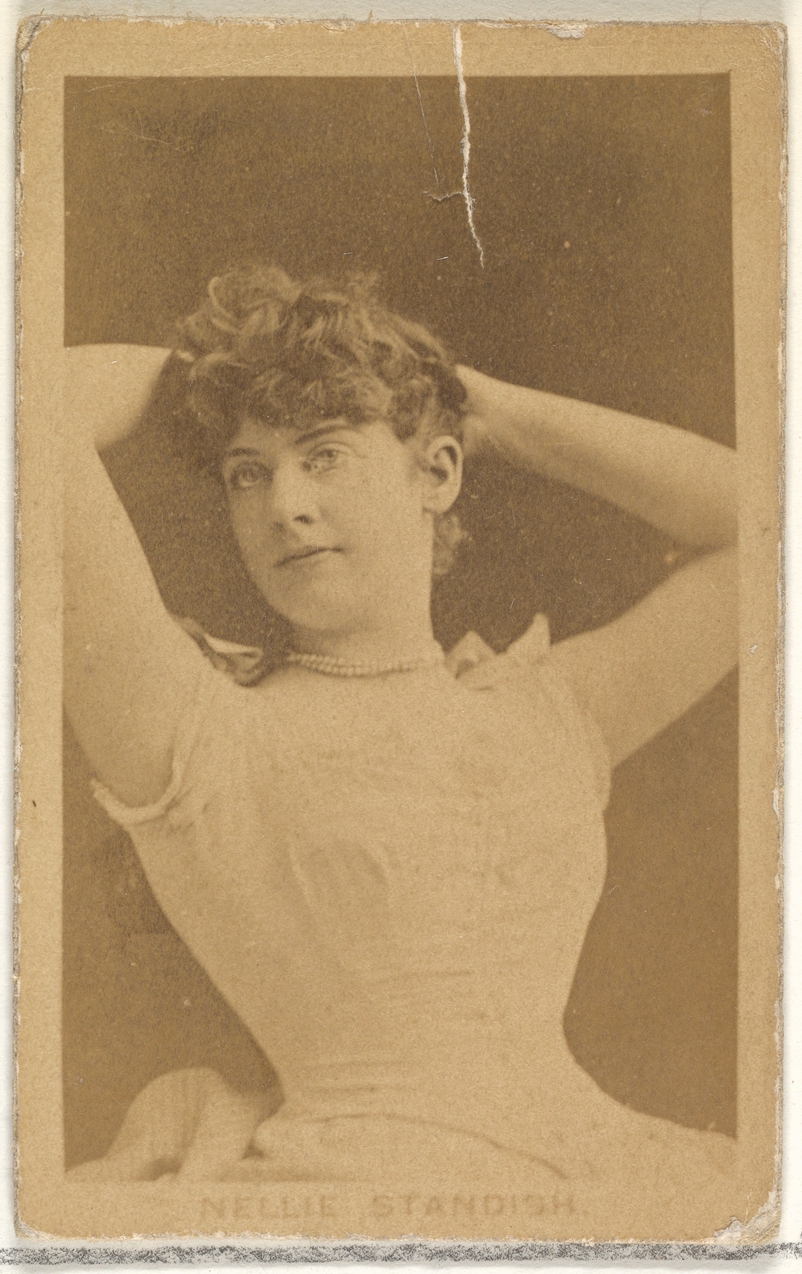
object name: photograph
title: Nellie Standish, from the Actors and Actresses series (N45, Type 1) for Virginia Brights Cigarettes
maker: allen & ginter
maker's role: publisher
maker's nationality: american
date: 1888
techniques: albumen silver print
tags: portraits,women,actresses